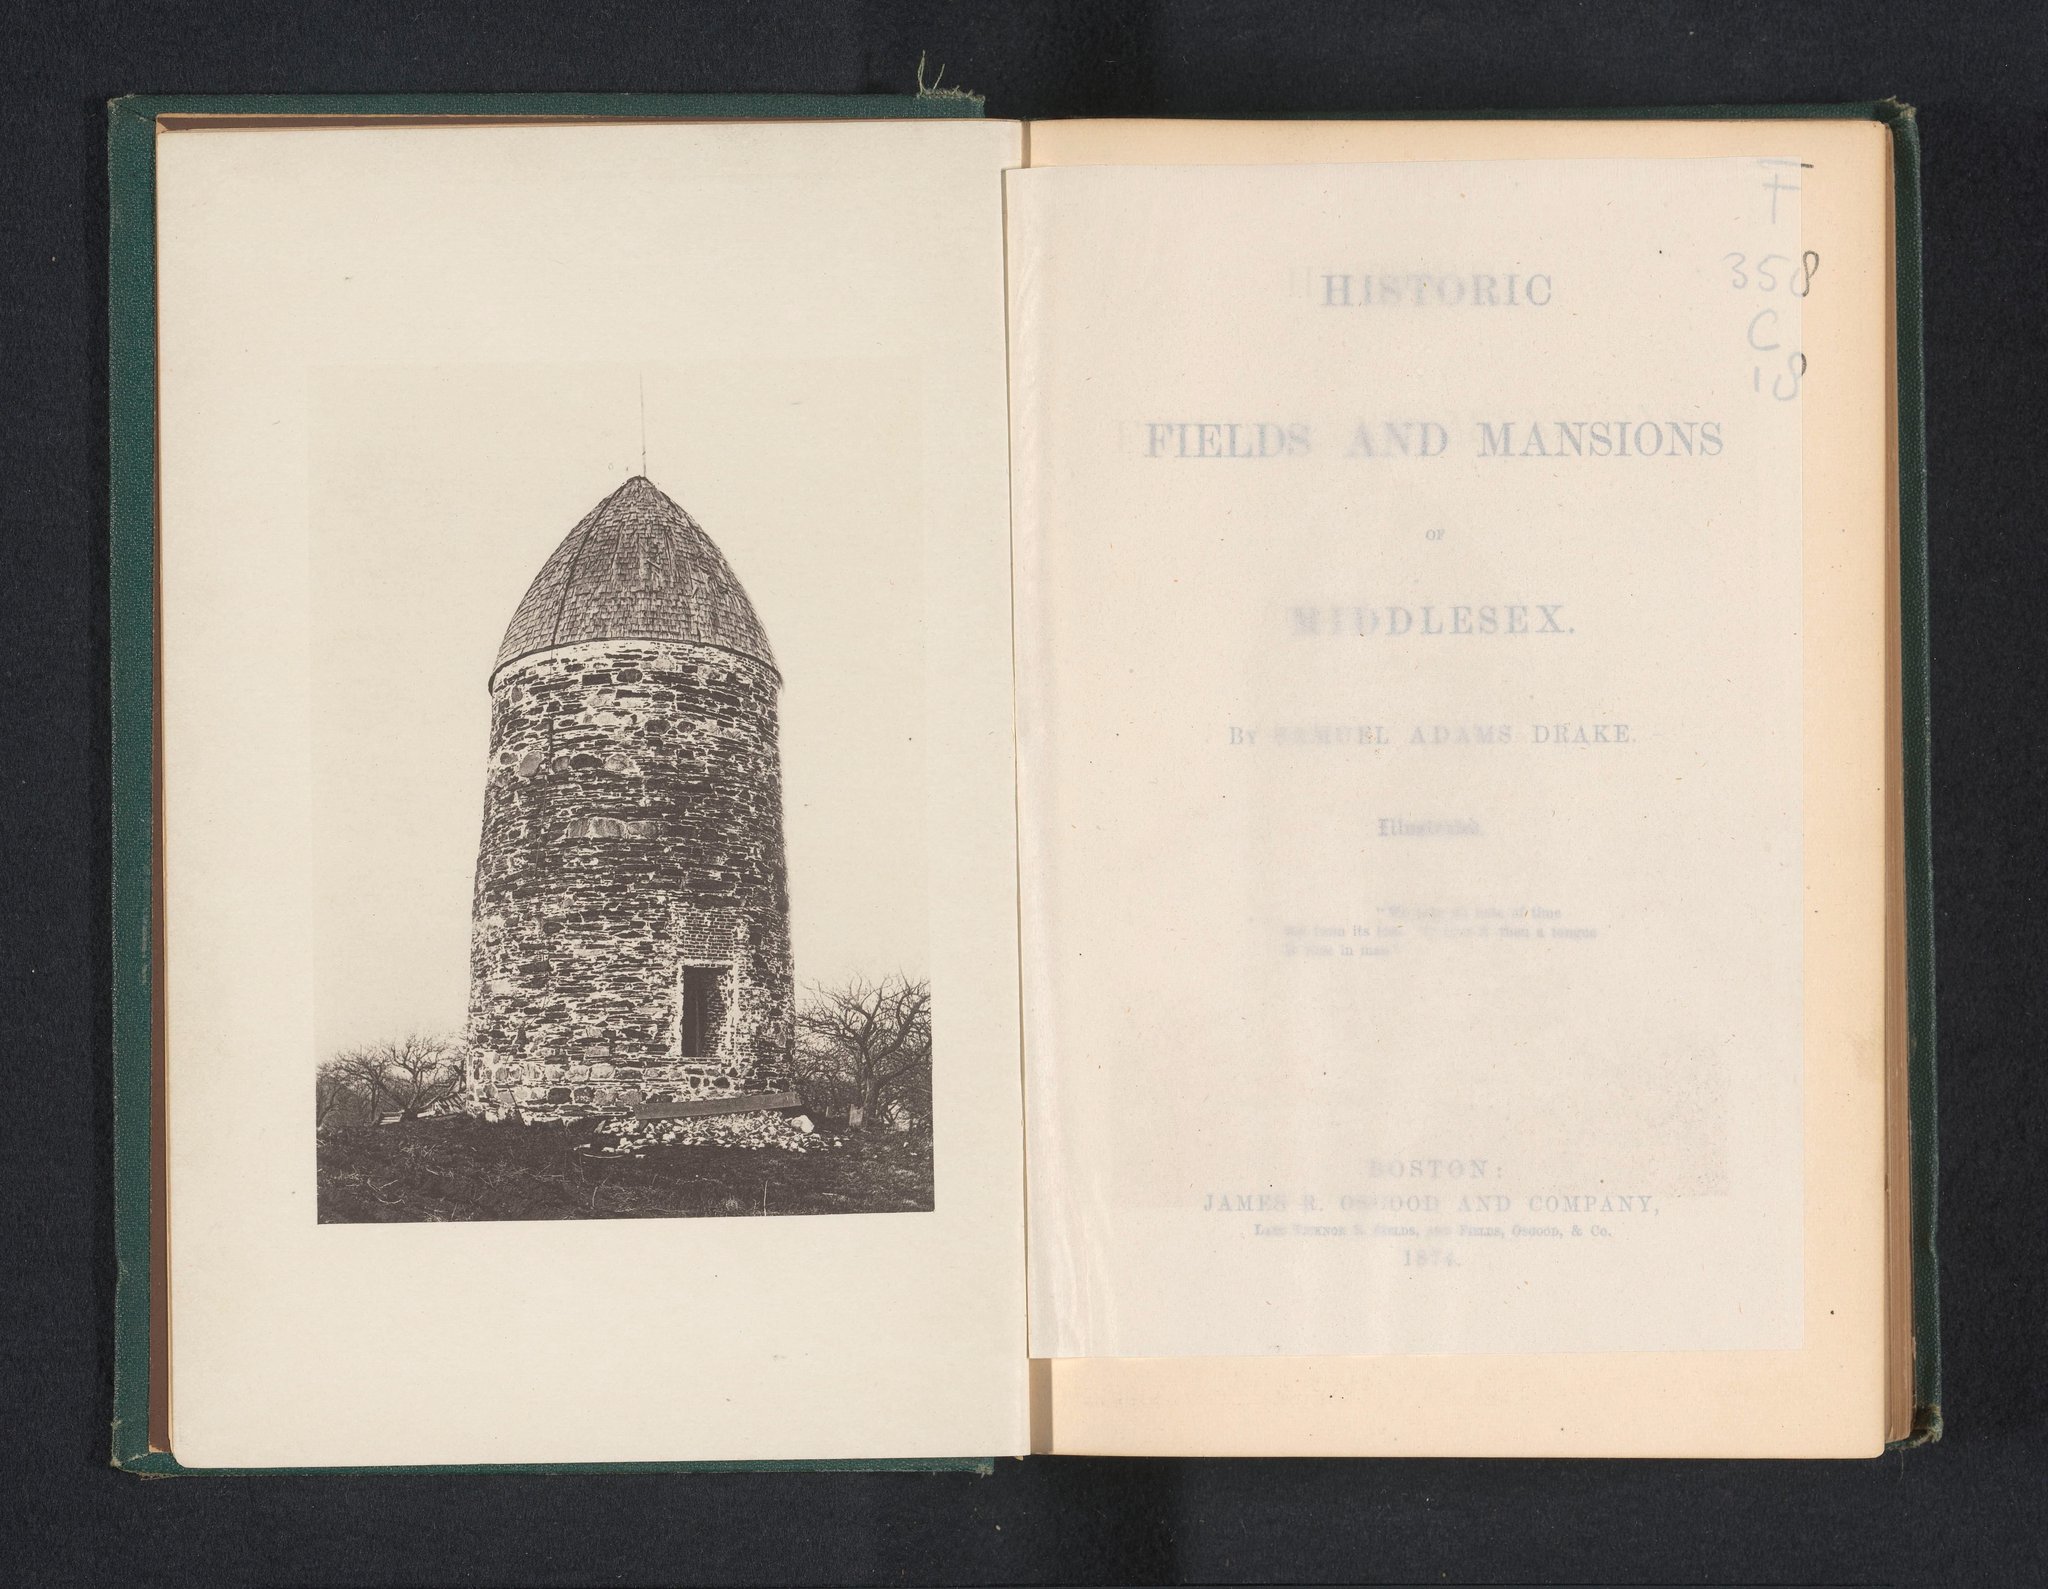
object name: photomechanical print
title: Gezicht op een oude molen te Somerville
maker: Anonymous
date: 1869-1874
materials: paper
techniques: photograph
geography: somerville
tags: factories and mills in landscape